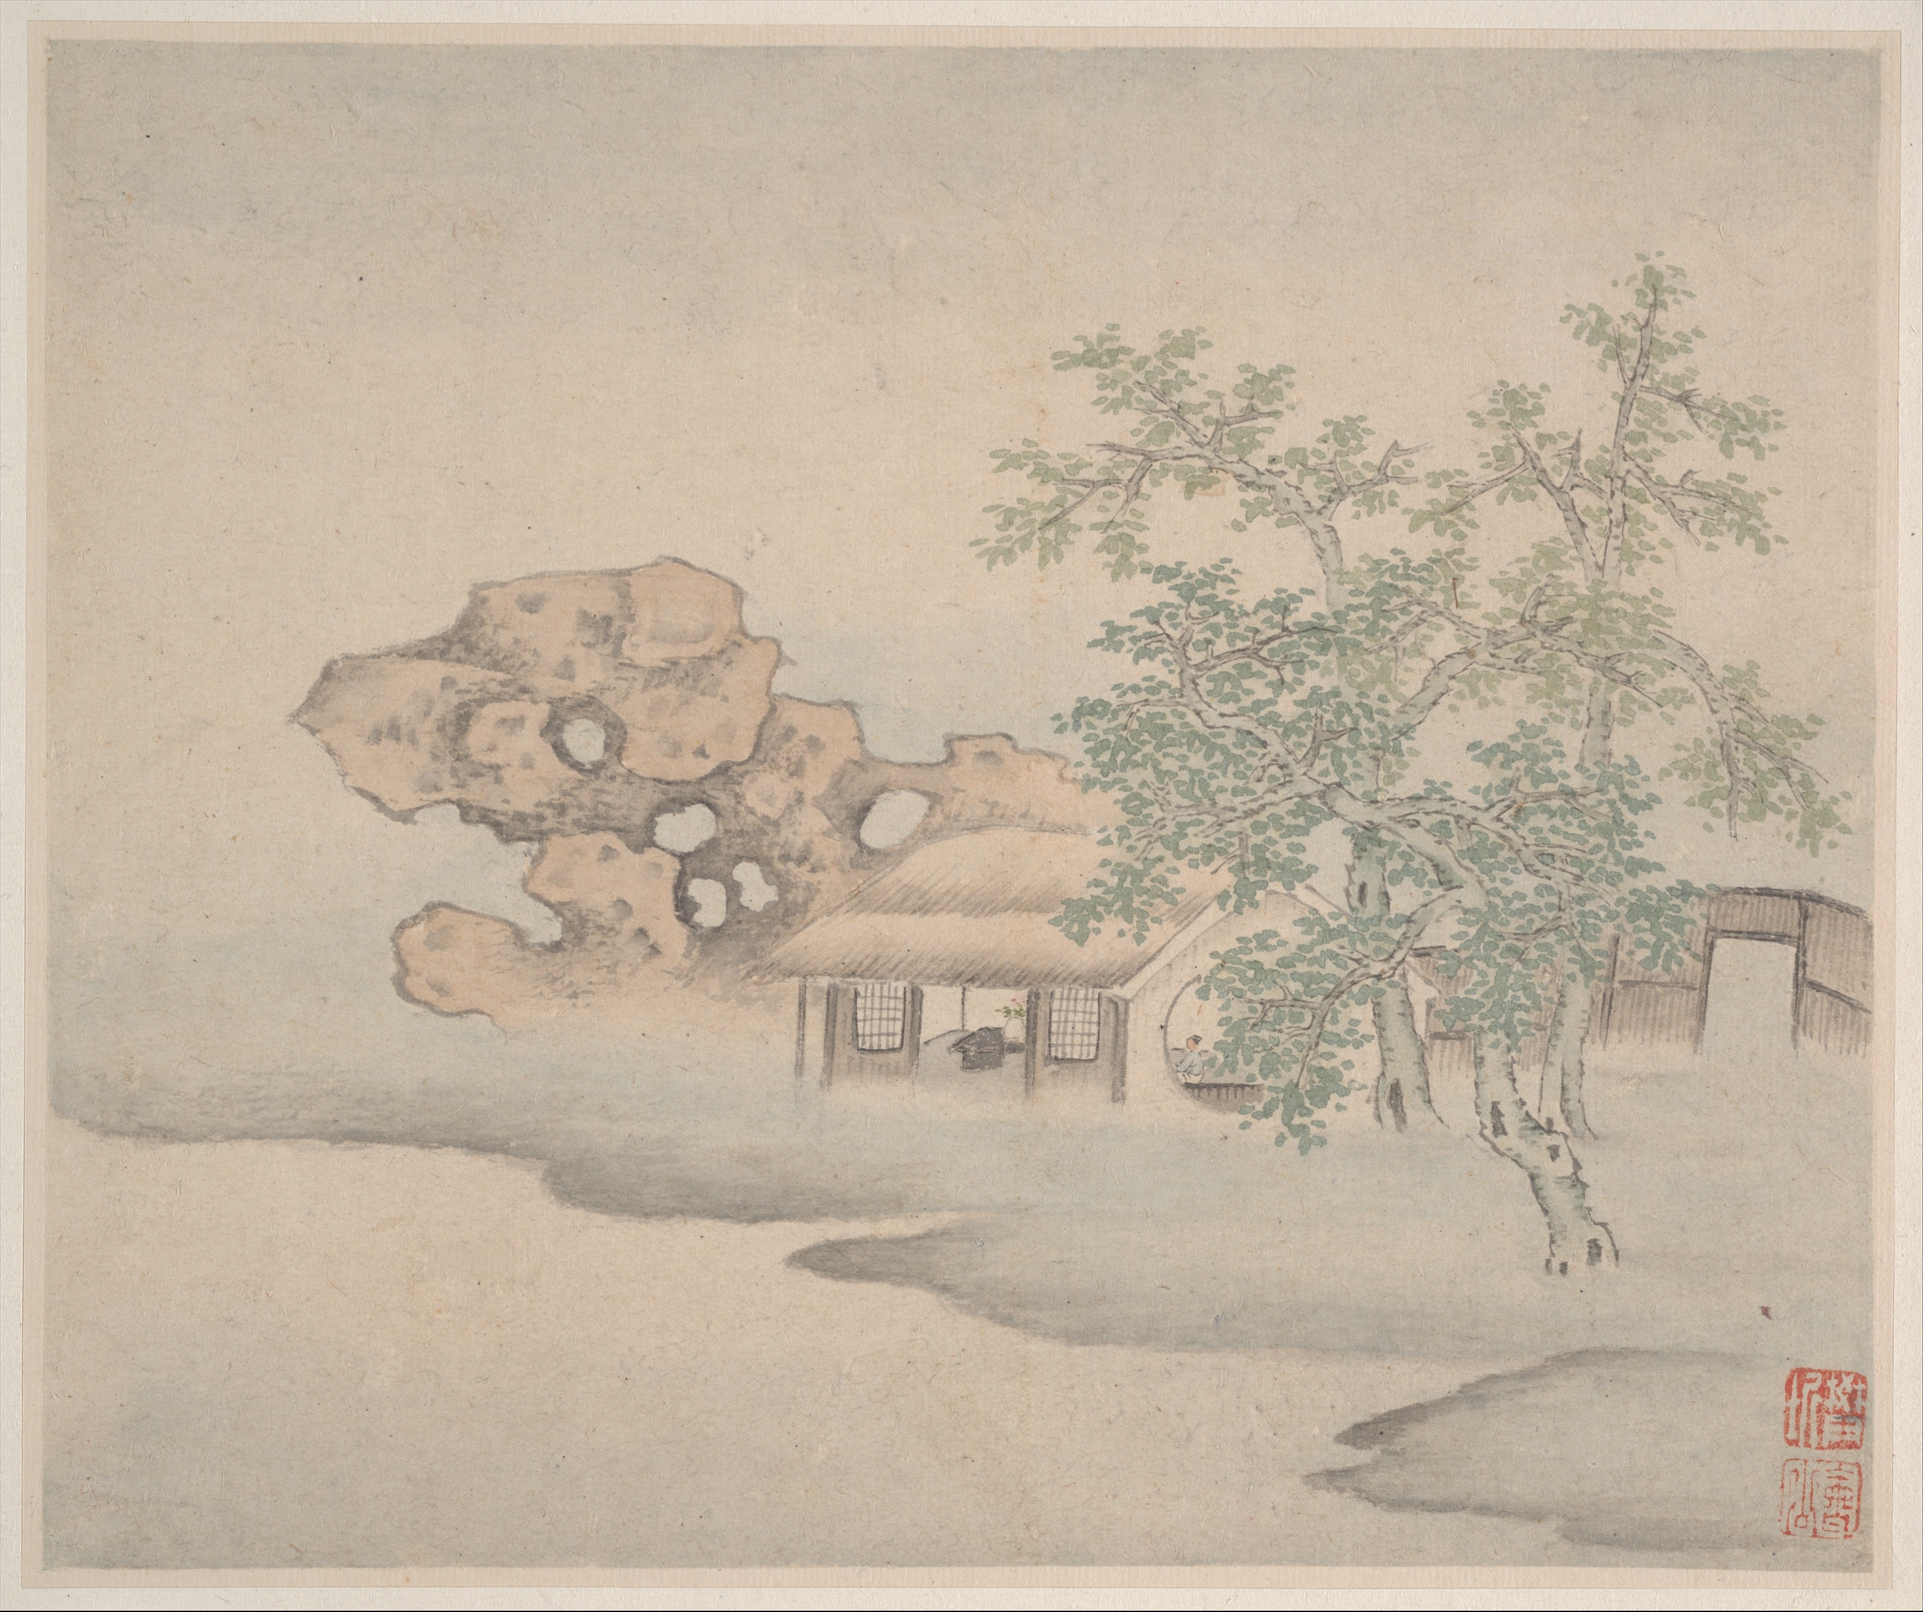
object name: album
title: Landscapes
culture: chinese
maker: fan qi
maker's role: artist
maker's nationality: chinese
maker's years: 1616-1694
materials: ink, paper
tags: landscapes